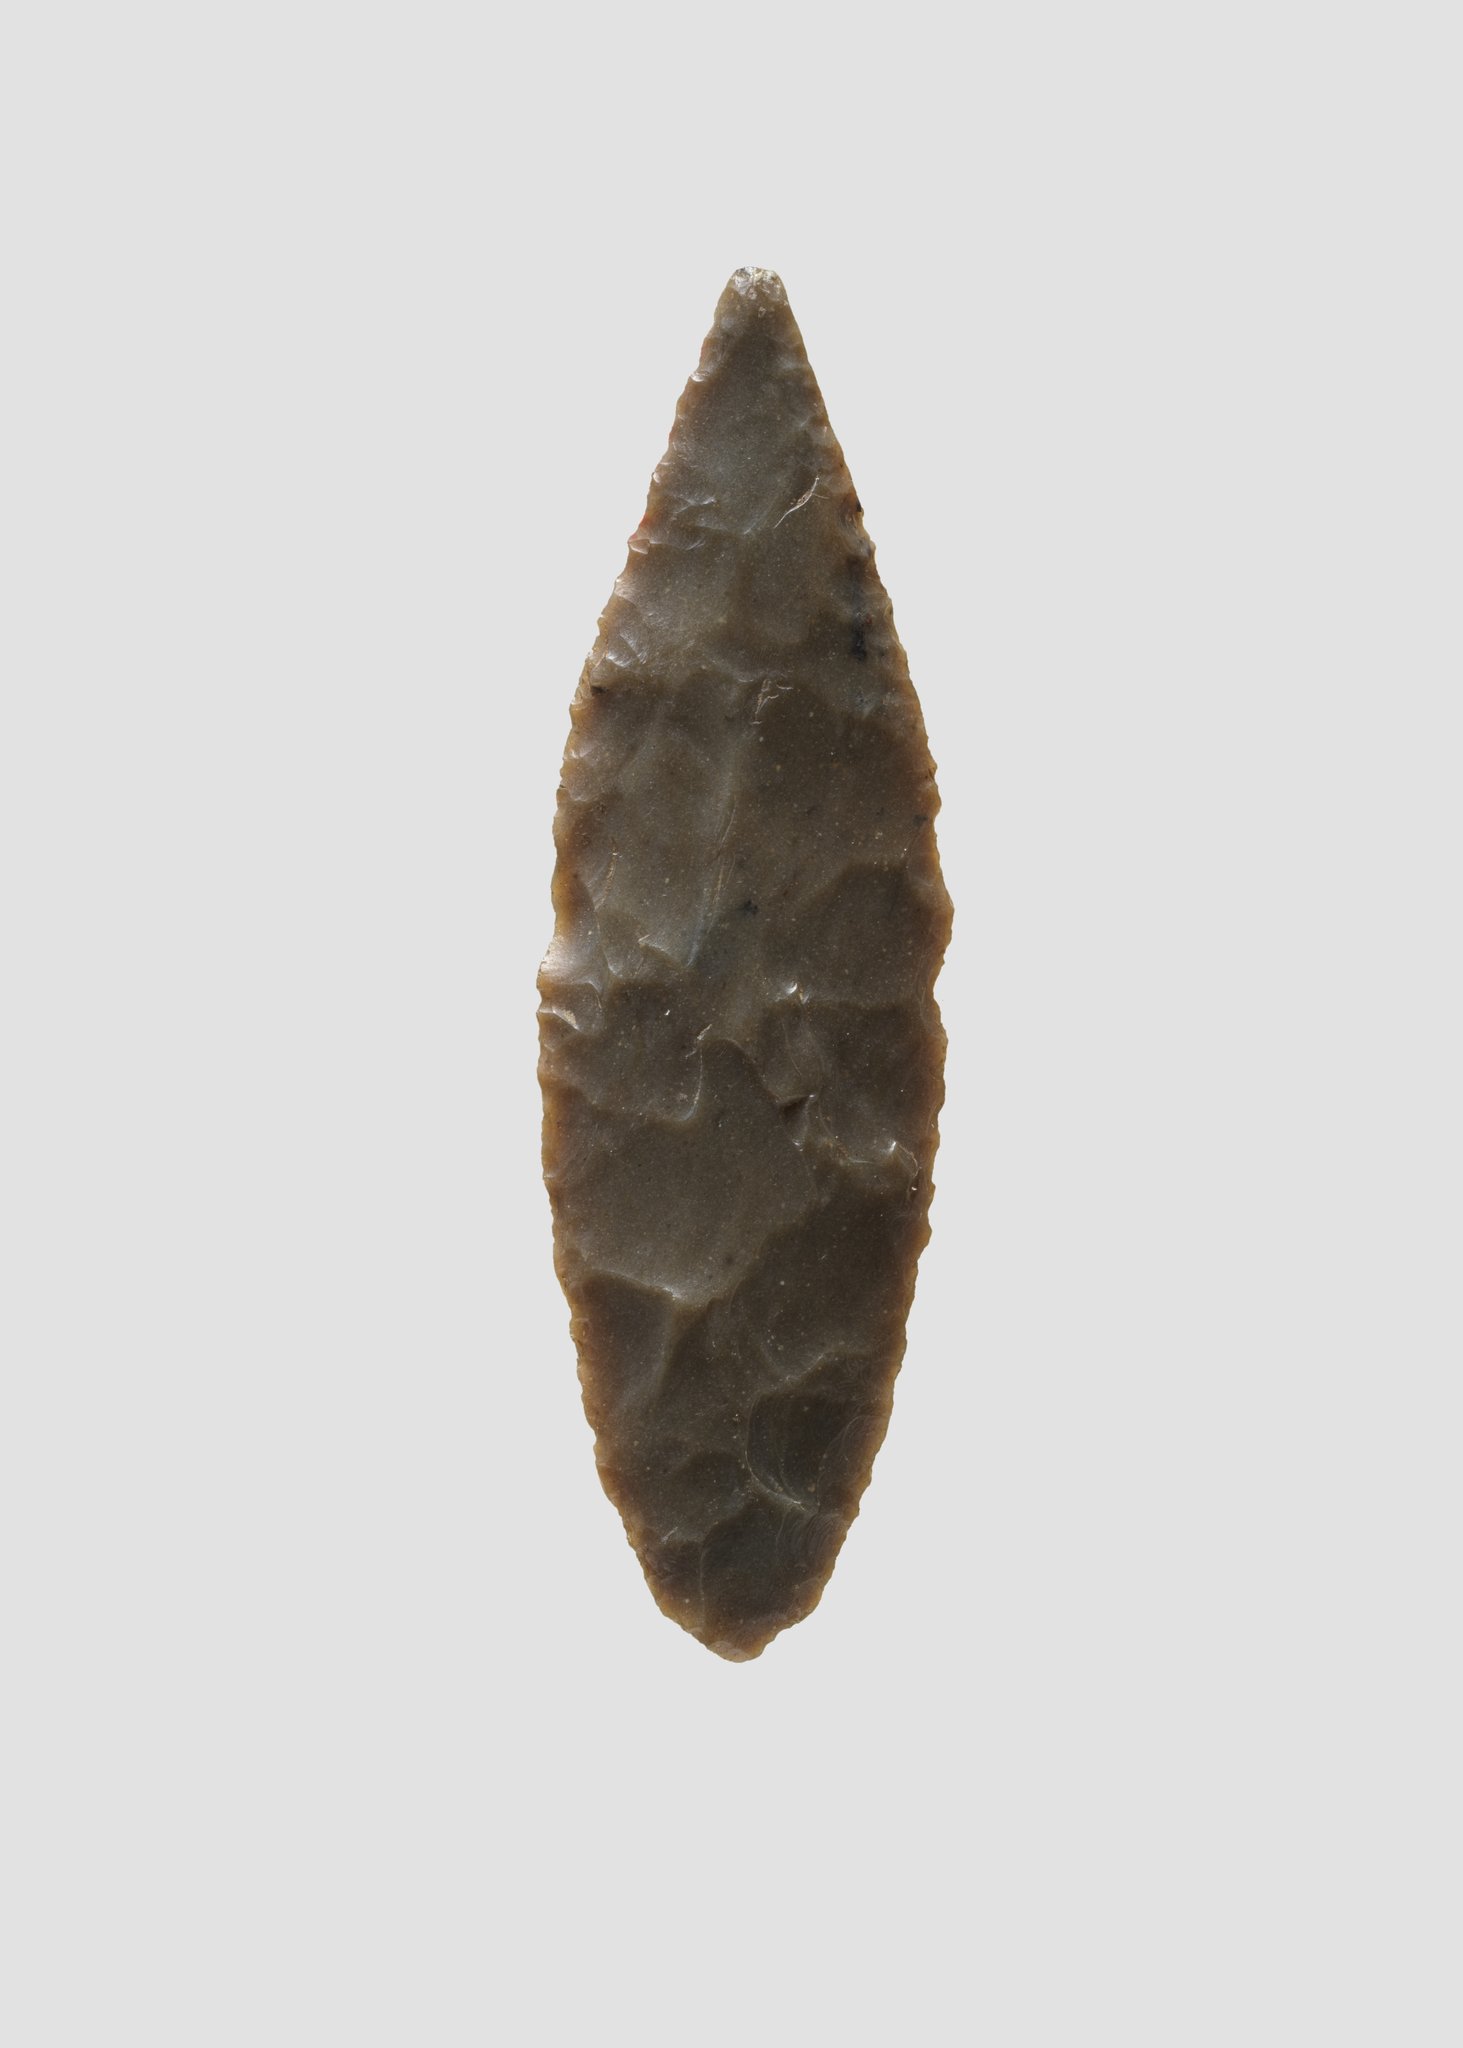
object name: point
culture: western asian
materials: stone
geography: western asia